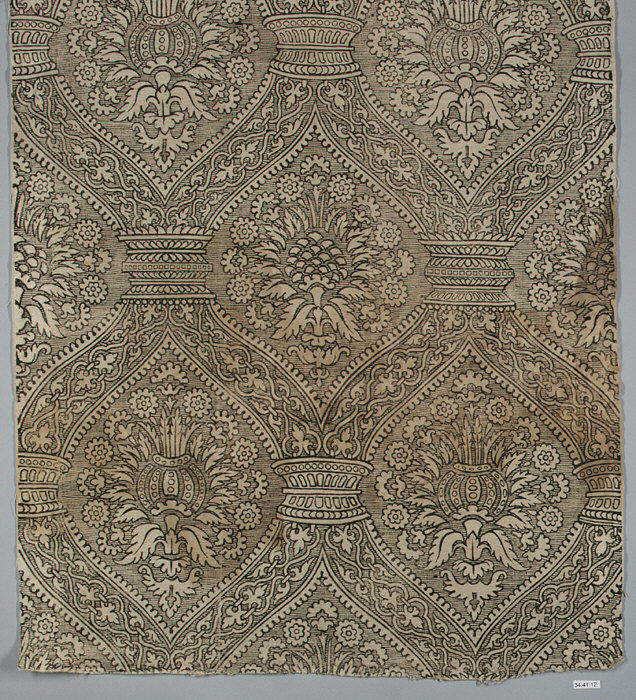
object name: piece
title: Length of block printed linen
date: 1501-1600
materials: linen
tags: flowers